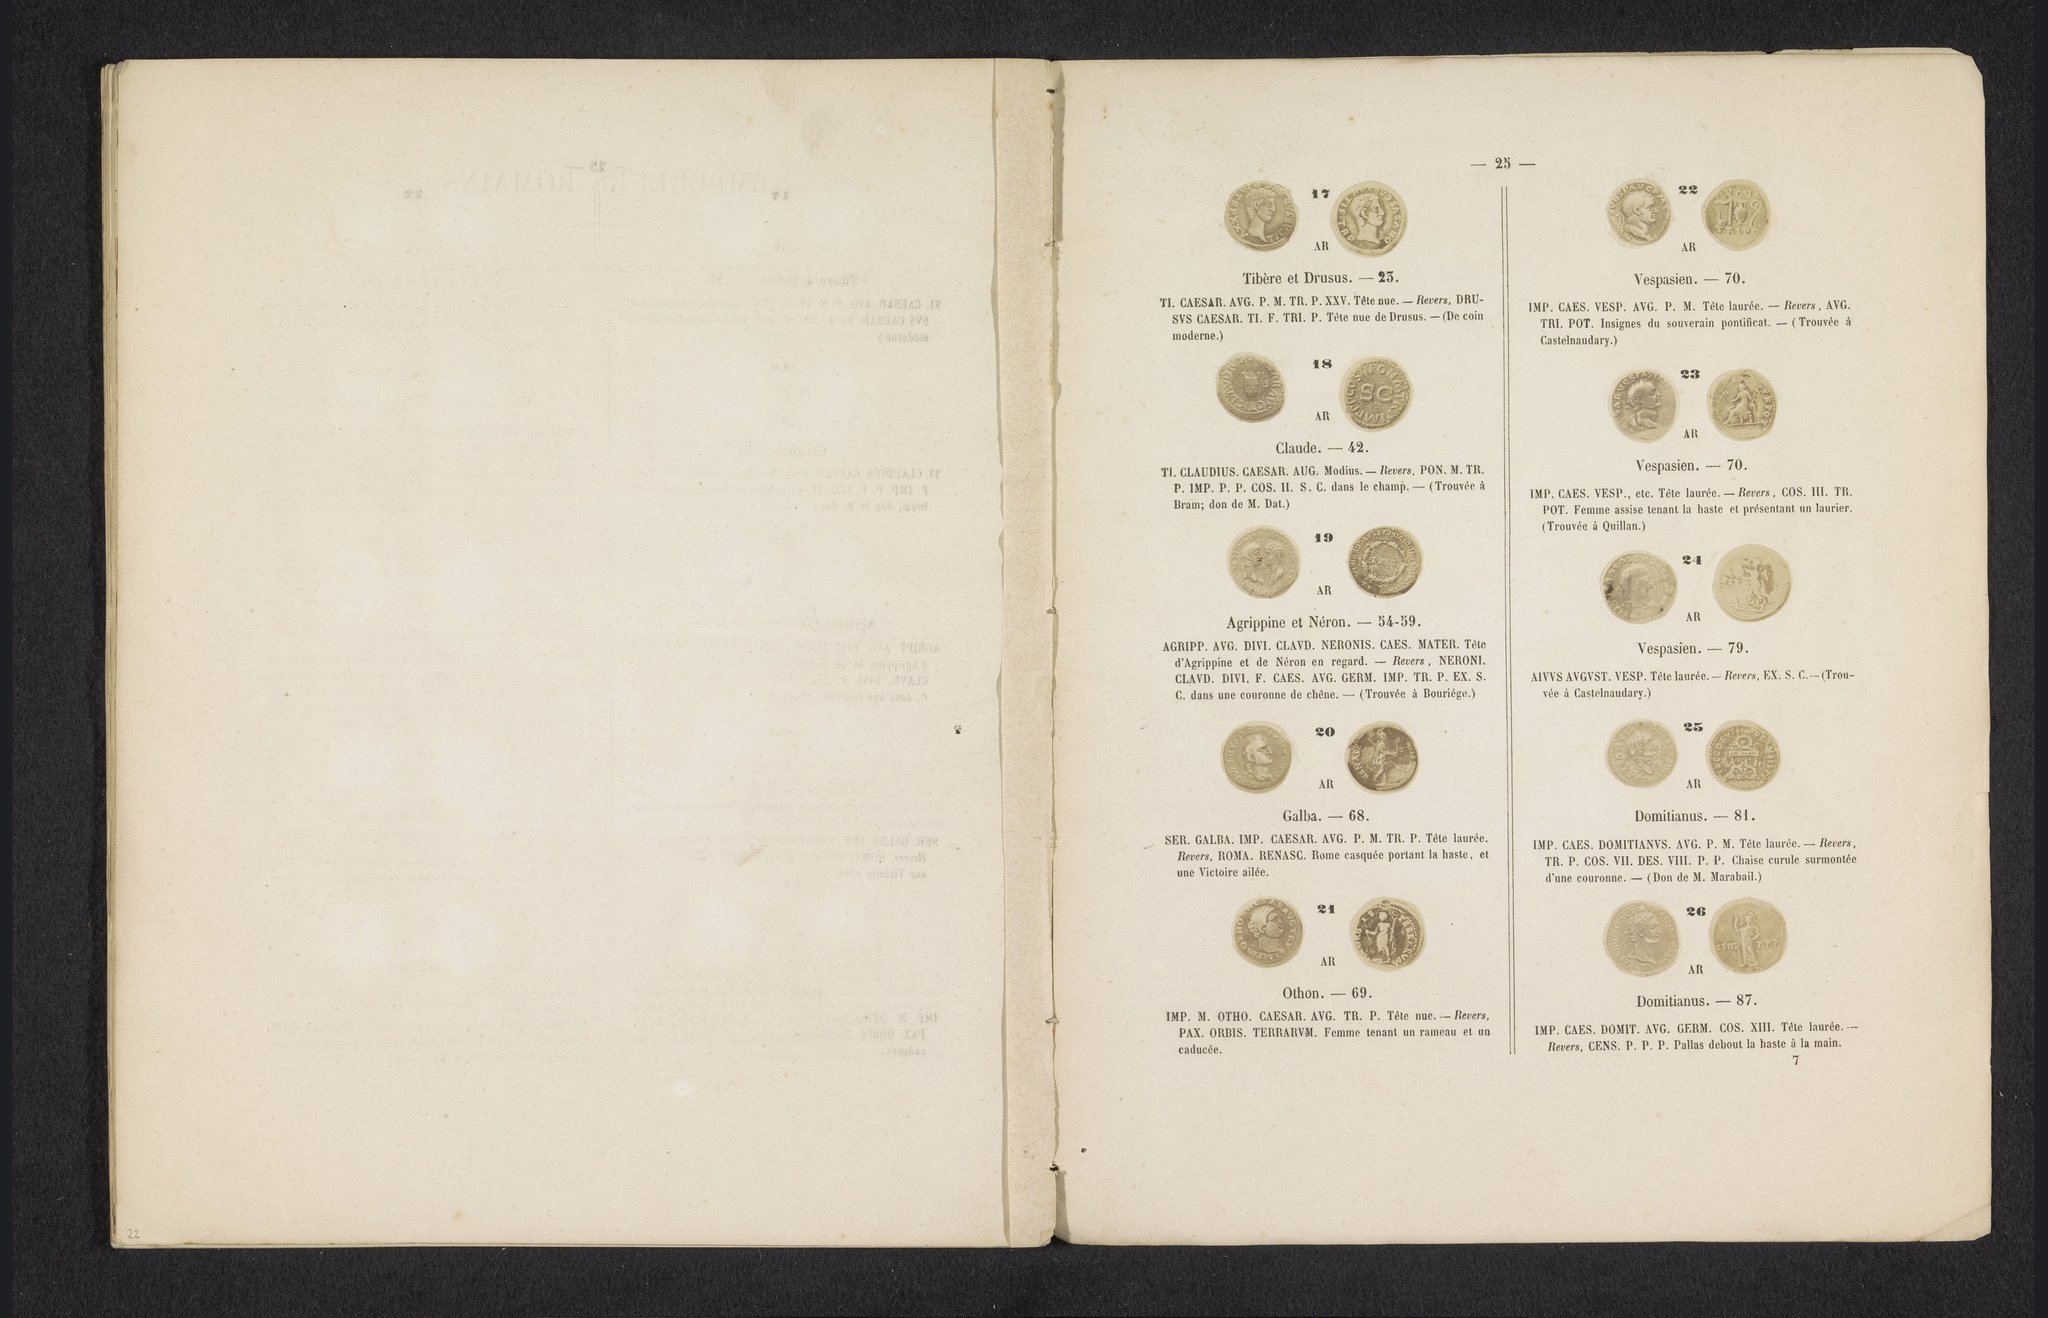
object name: page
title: Tien munten met Romeinse keizers, gezien van voor- en achterkant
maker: léopold verguet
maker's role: abt, fotograaf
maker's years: 1817-1914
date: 1854-1864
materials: photographic support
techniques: albumen print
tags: miseno, coin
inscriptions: number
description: Nummers 17 tot en met 26: Tiberius en Drusus, Claudius I, Agrippa en Nero, Galba, Otho, Vespasianus, Vespasianus, Domitianus en Domitianus.